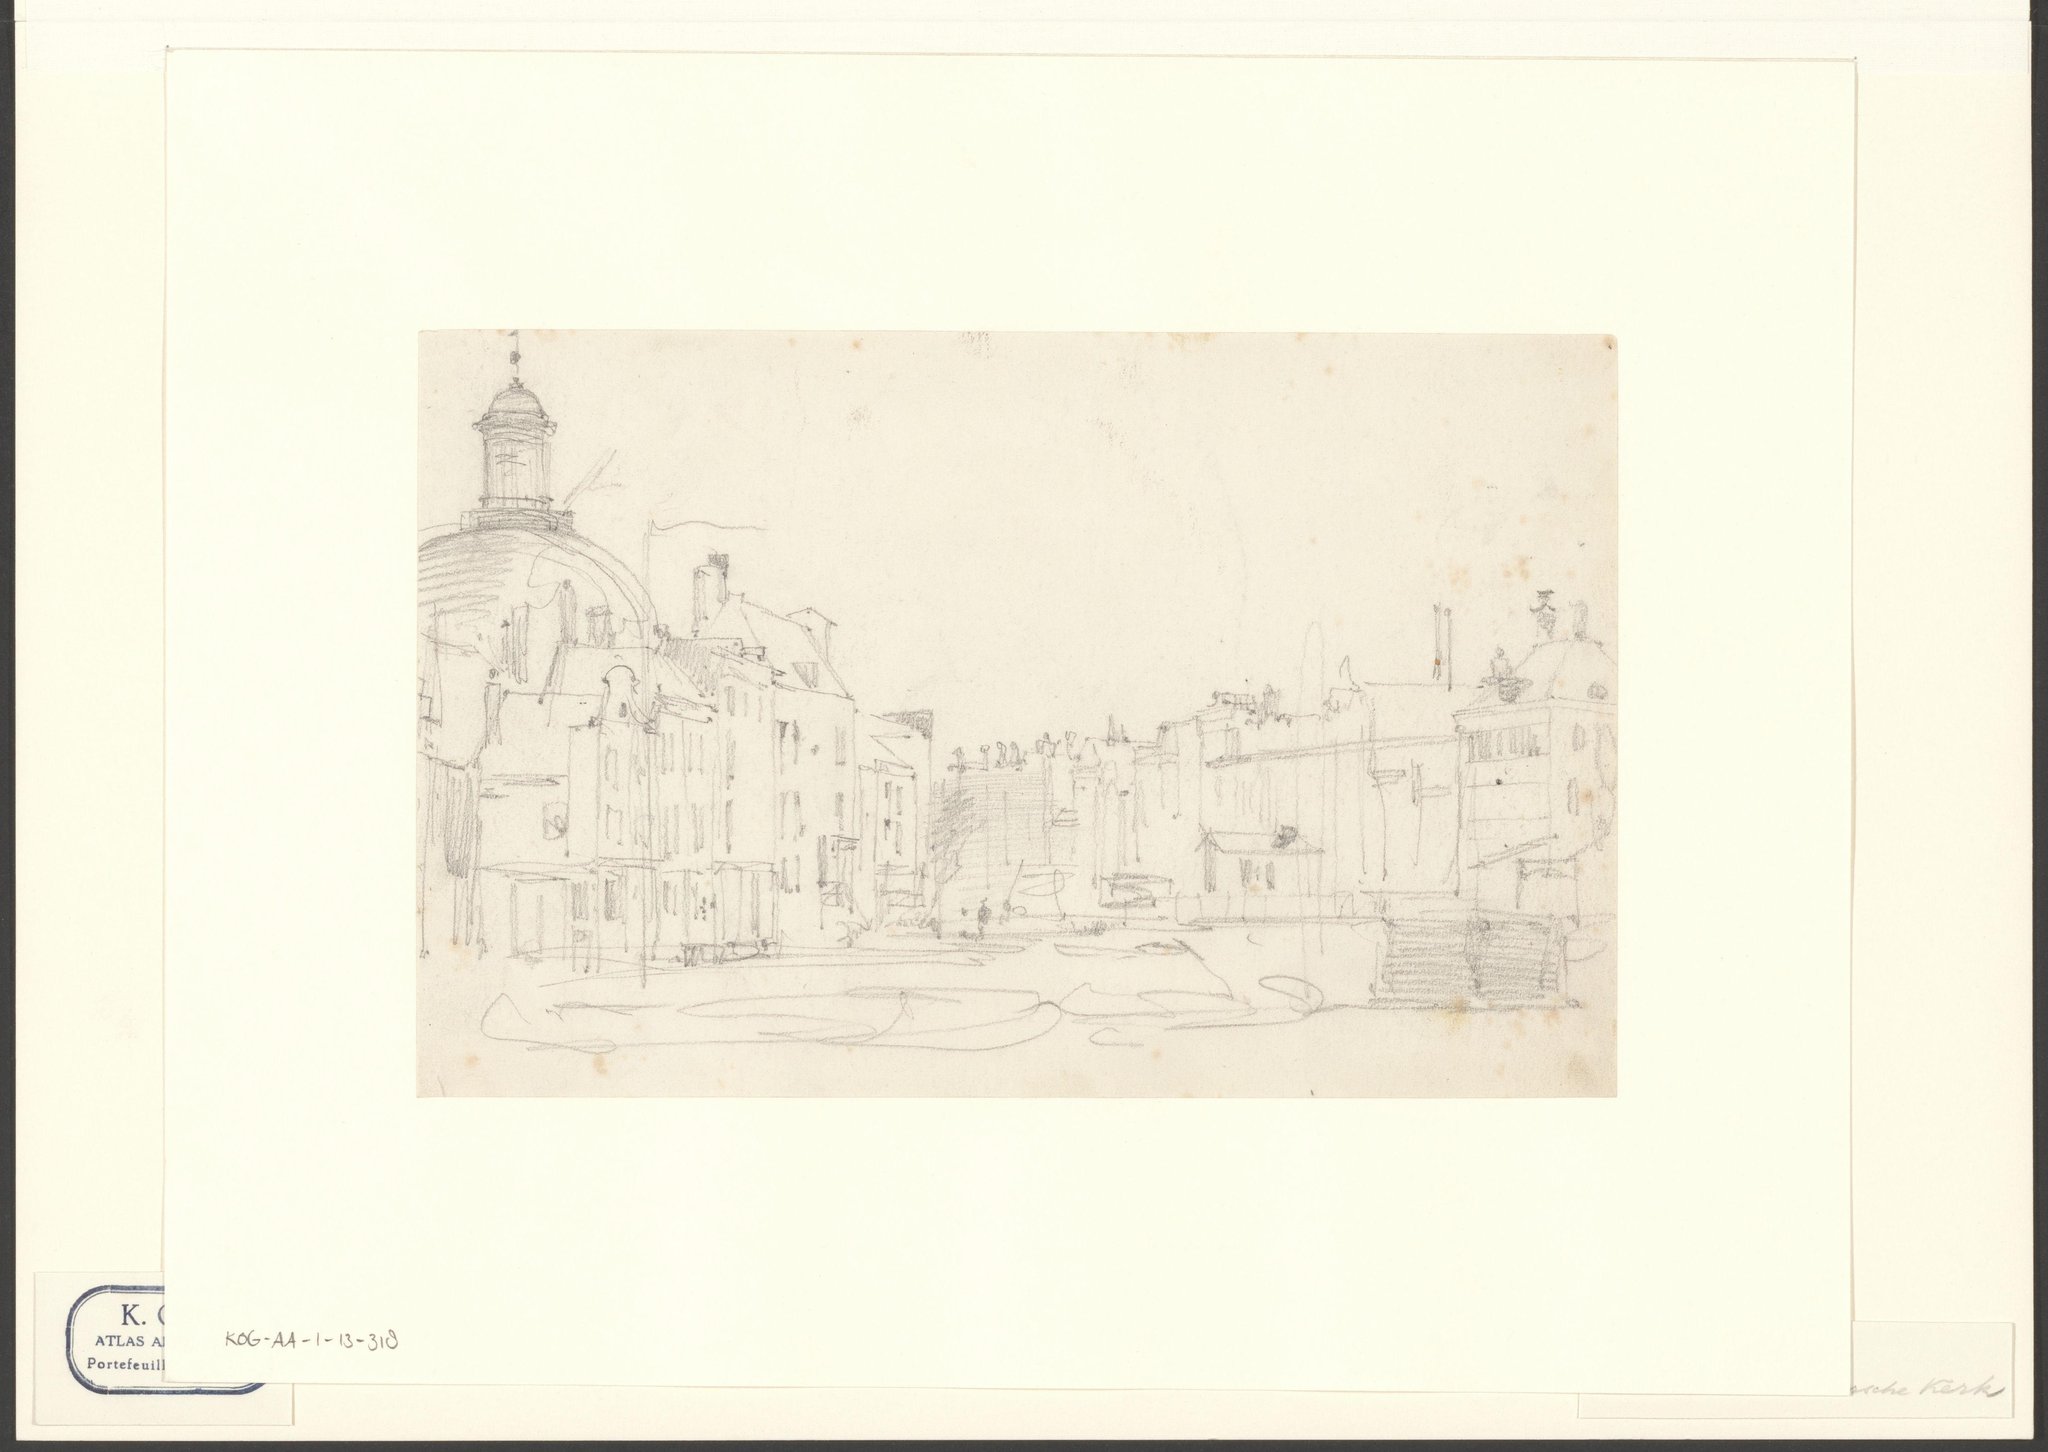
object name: drawing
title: Gezicht op het Singel en de koepel van de Oude Lutherse Kerk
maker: Anonymous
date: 1850-1950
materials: paper, pencil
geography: amsterdam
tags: city-view in general; 'veduta', parts of church exterior and annexes: dome, canal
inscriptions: collector's mark: ‘13’ Lugt 1641b, inscription: ‘Port. 13-318’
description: Onderwerpsrubriek binnen de Atlas Amsterdam: Oude Schans, Schoutensteeg, Singel (Korte), Singel.